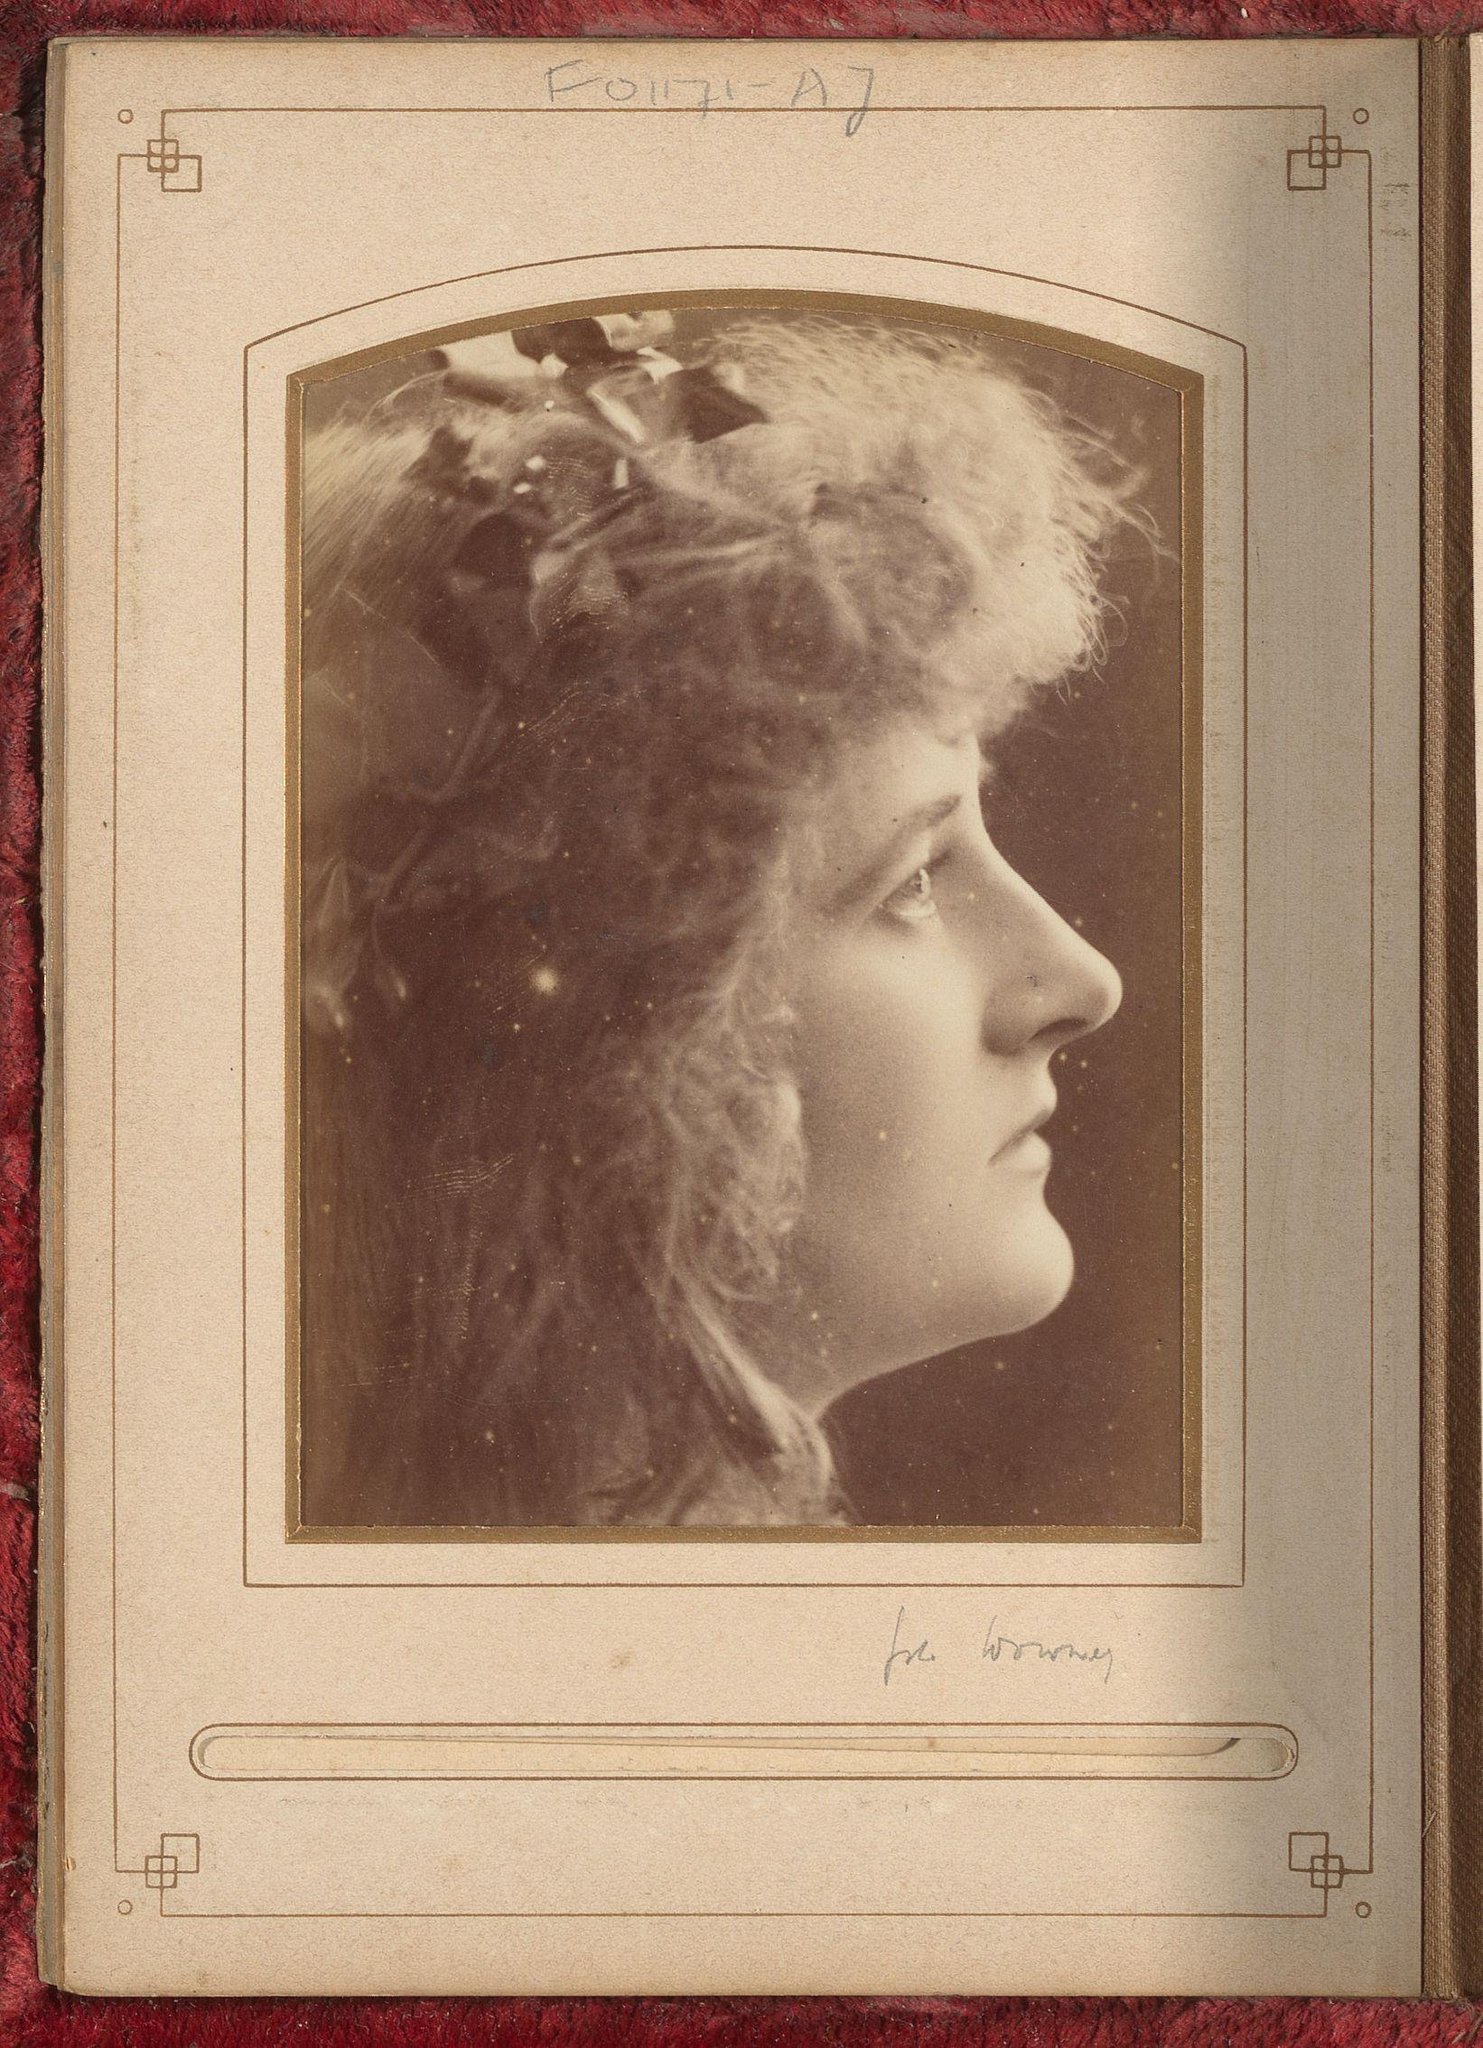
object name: album leaf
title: Portret van een vrouw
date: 1870-1900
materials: cardboard, photographic support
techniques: albumen print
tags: adult woman